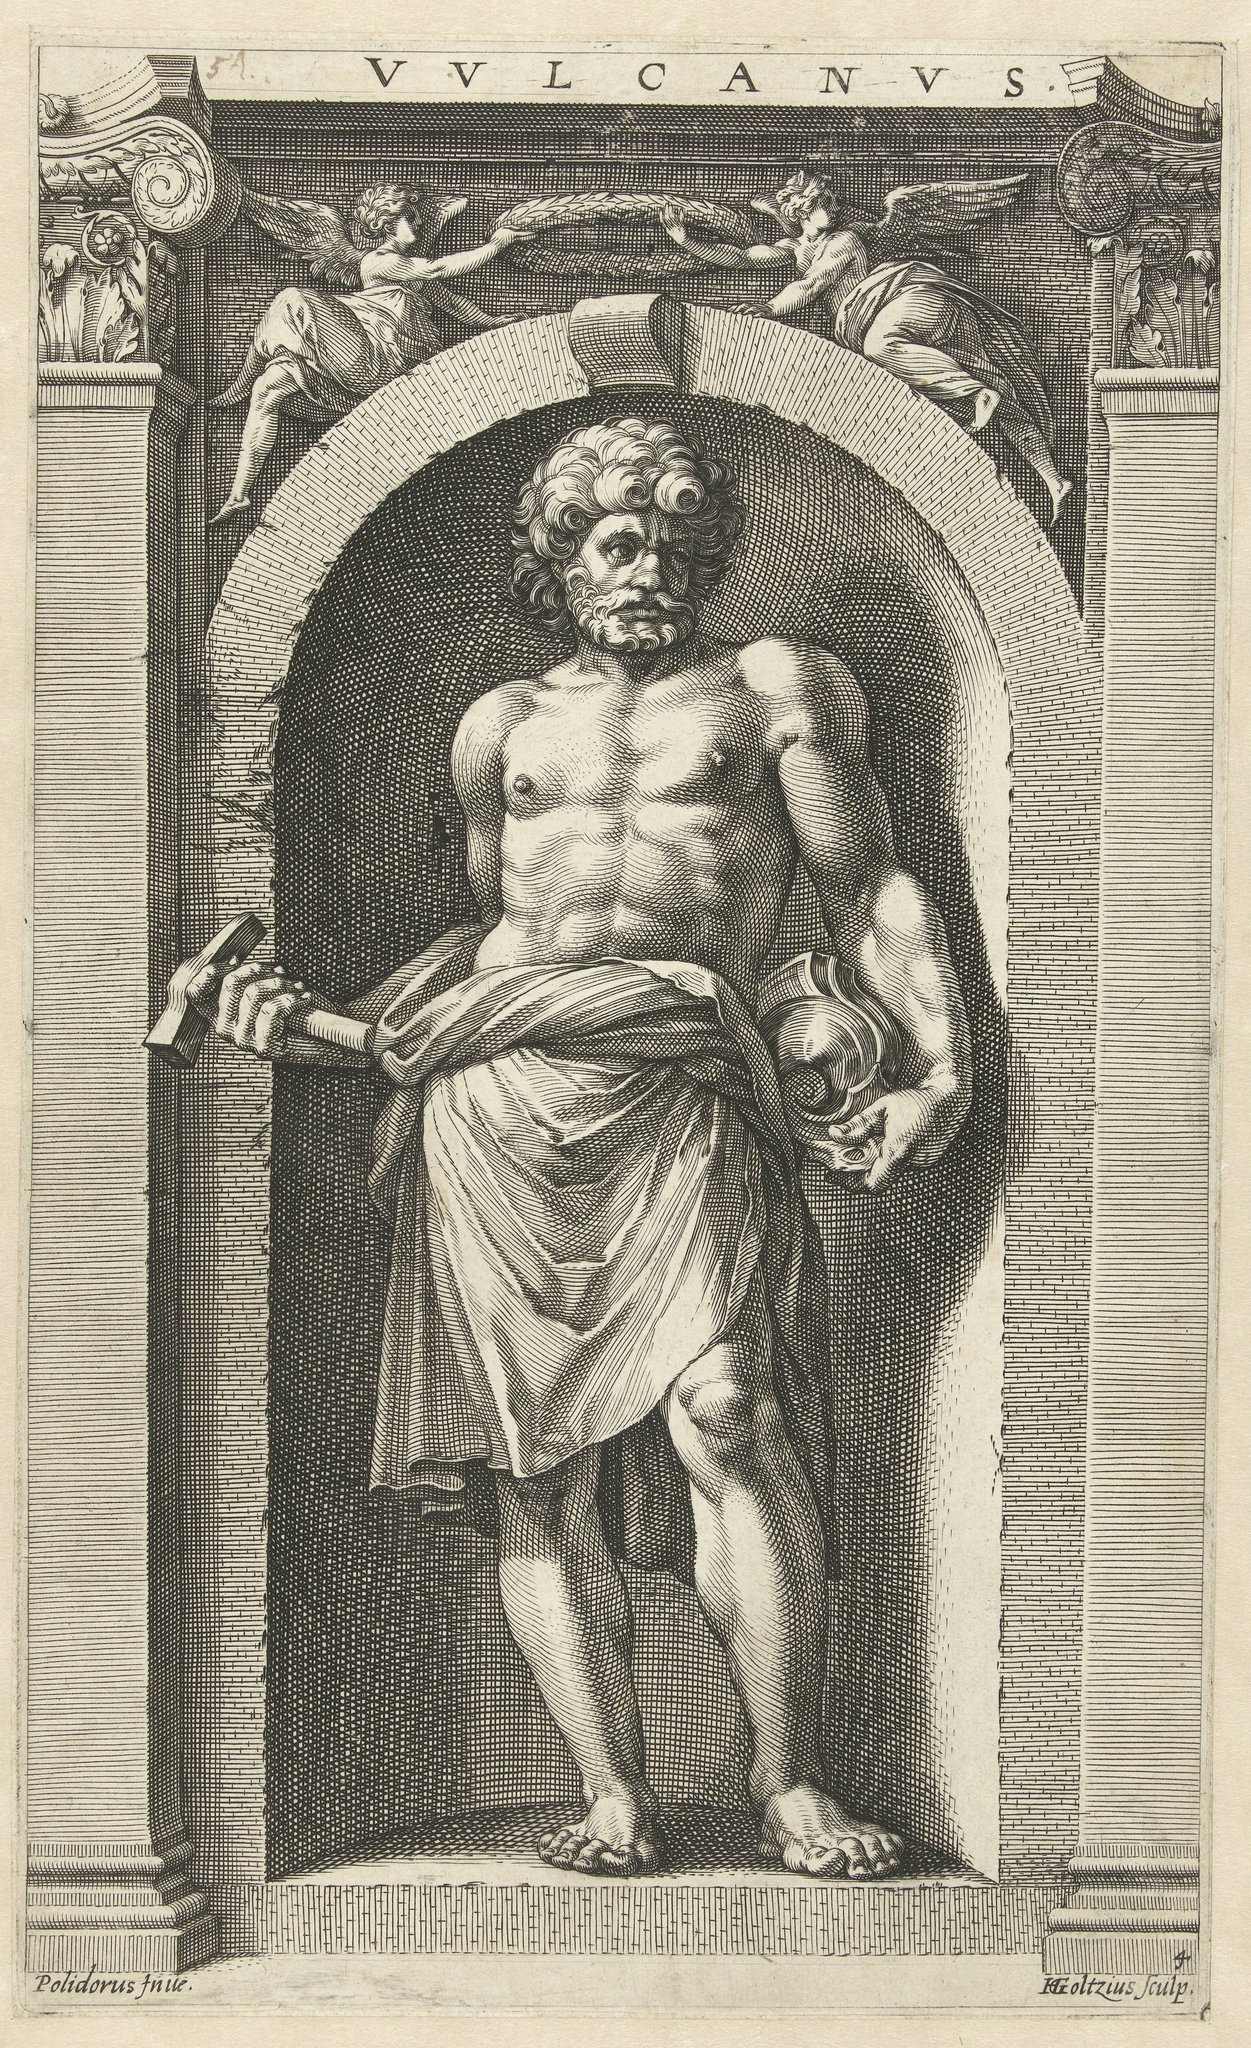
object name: print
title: Acht klassieke goden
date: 1592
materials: paper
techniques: engraving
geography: haarlem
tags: (story of) vulcan (hephaestus)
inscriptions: collector's mark: Lugt 11, collector's mark: Lugt 10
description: Vulcanus, staand in een nis, een hamer in zijn rechterhand, een helm in zijn linkerhand. Deze prent is onderdeel van een serie van acht prenten van klassieke goden, gebaseerd op schilderingen van Polidoro da Caravaggio op de façade van een Romeins huis, door Goltzius in Rome gezien en nagetekend.